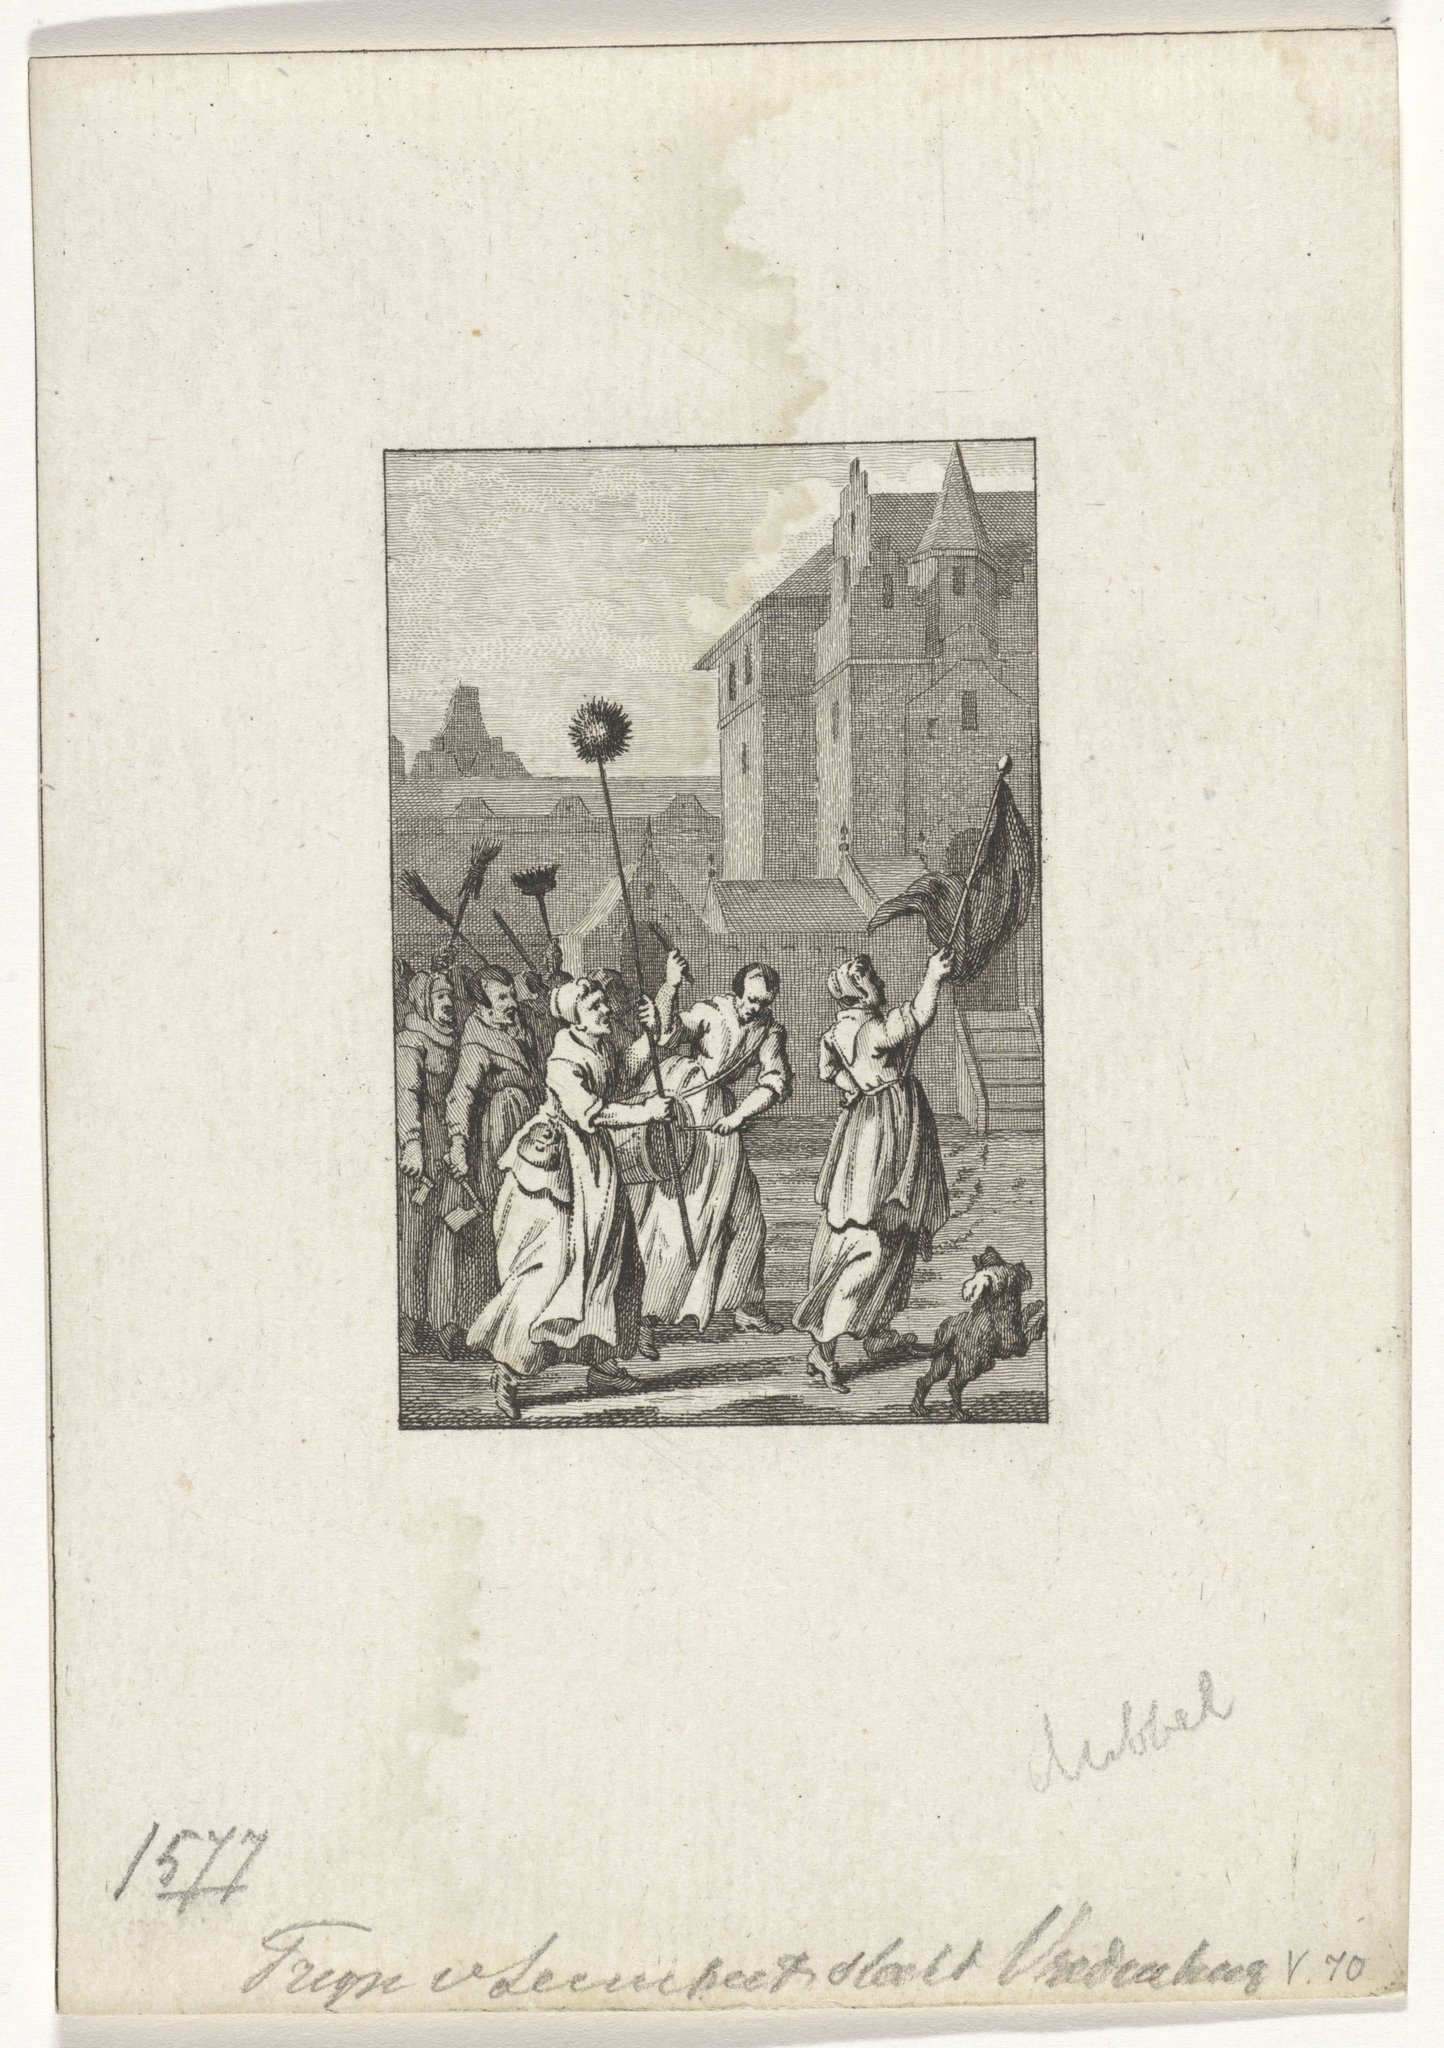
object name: print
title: Trijn van Leemput trekt met een groepje vrouwen op naar kasteel Vredenburg, 1577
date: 1783-1795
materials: paper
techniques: etching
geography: amsterdam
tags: utrecht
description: Trijn van Leemput trekt met een groepje vrouwen gewapend met hamers en pikhouwelen op naar het kasteel Vredenburg, 2 mei 1577. Voorop loopt een vrouw met een vlag, daarachter een vrouw die op een trom slaat en een vrouw met een ragebol.